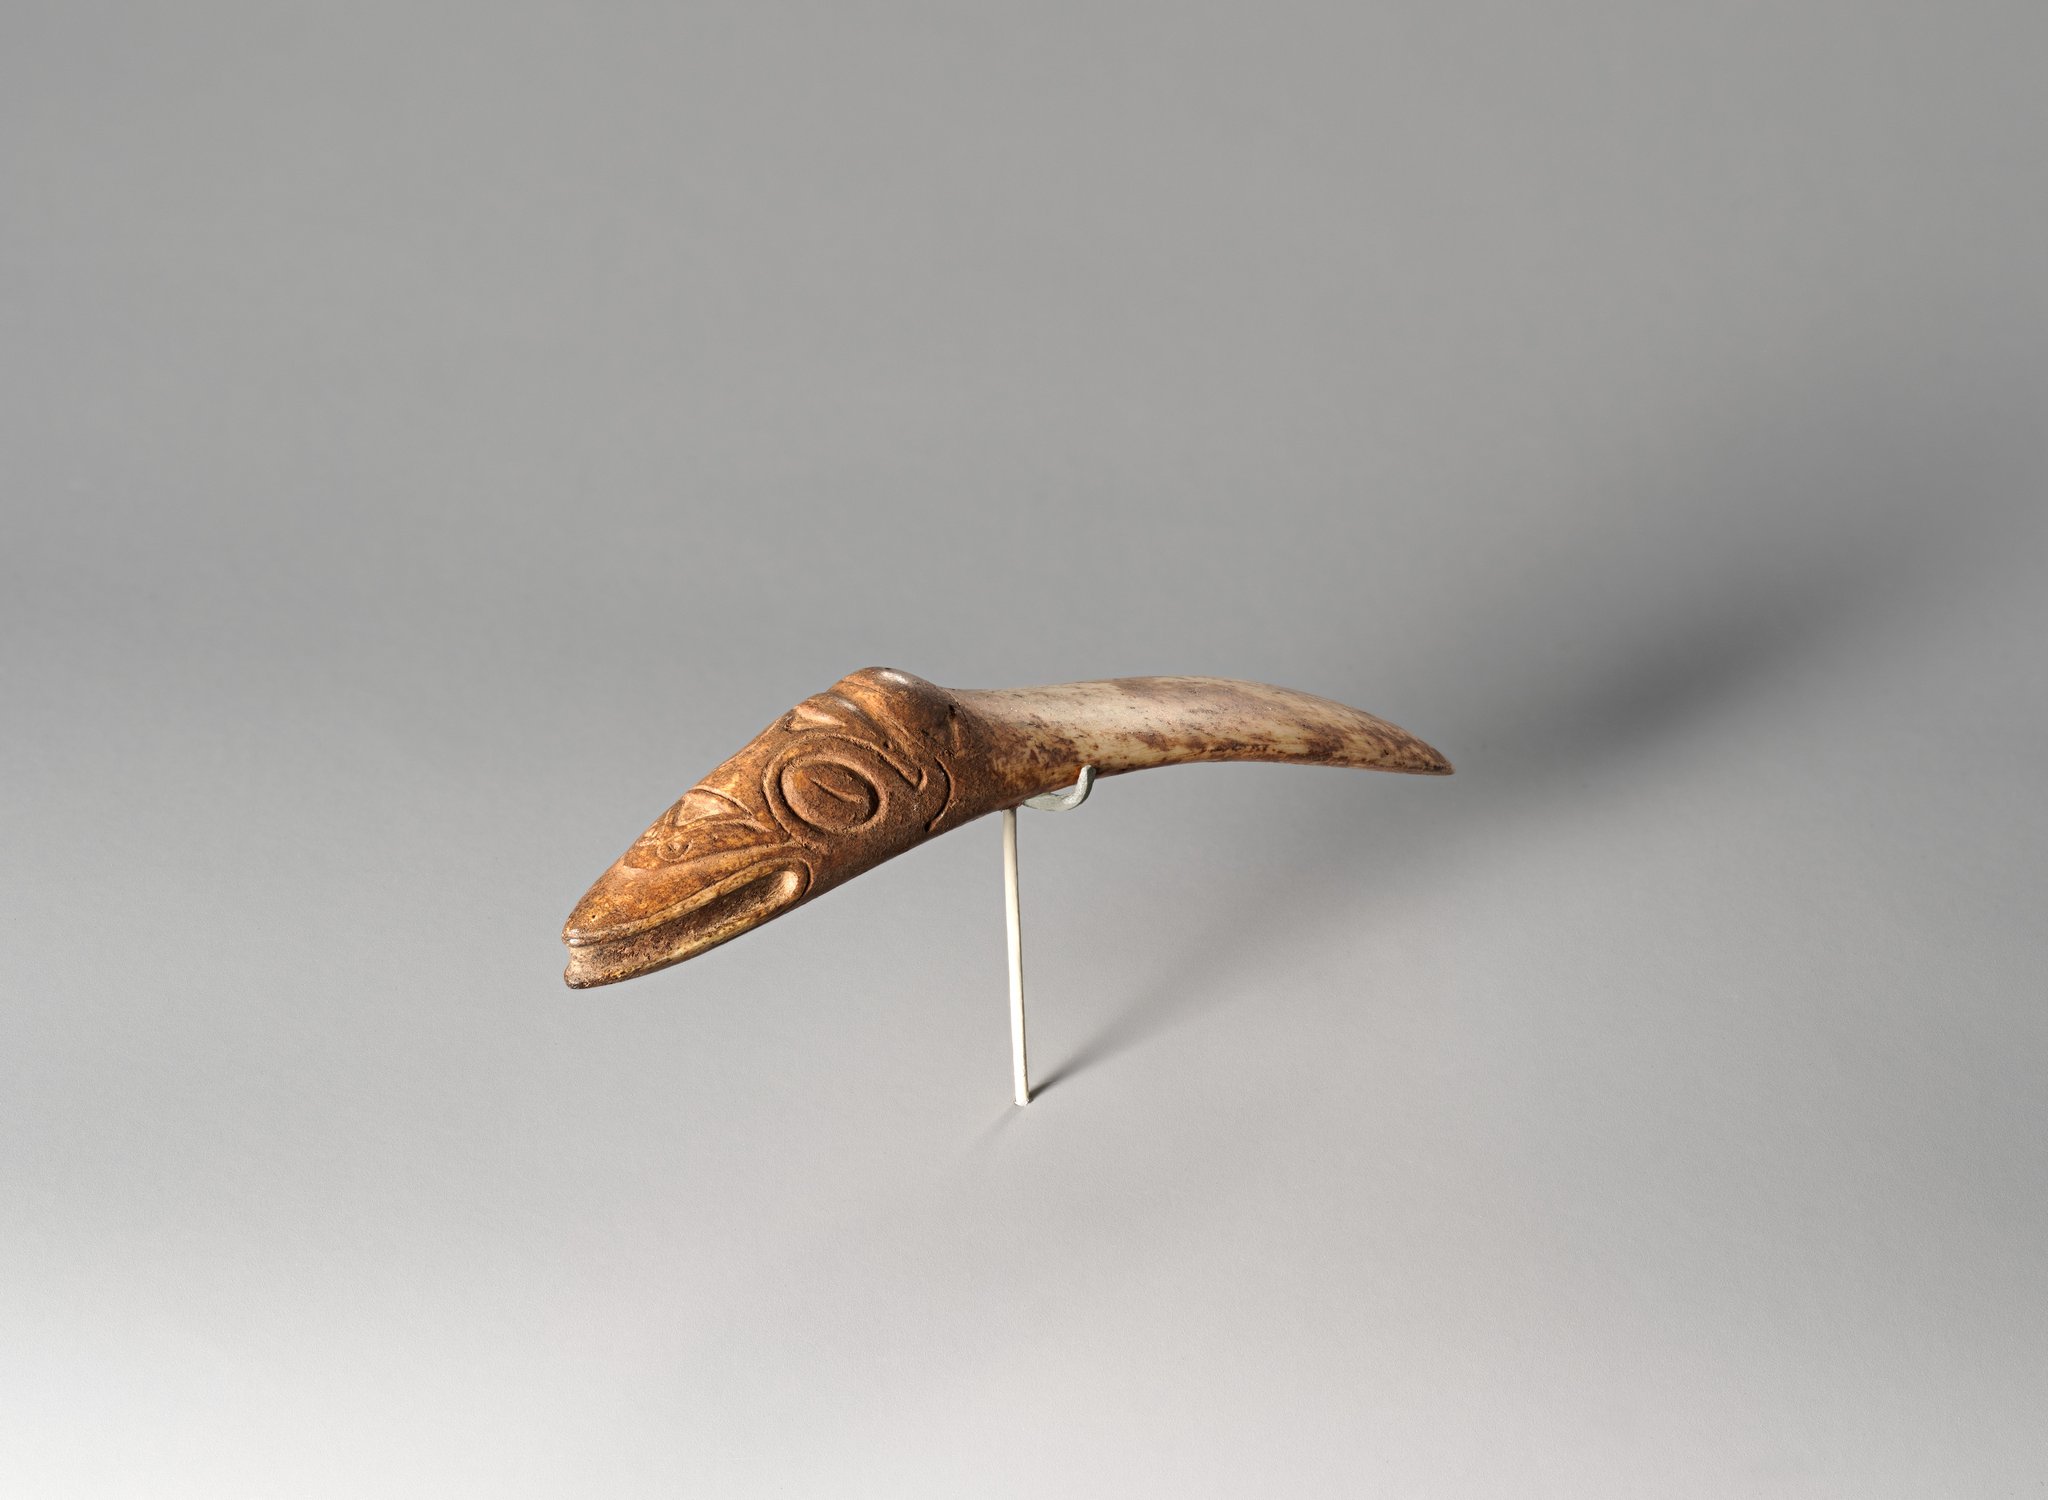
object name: spatula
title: Spatula (Vomitivo), Lizard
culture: taíno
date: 1201-1500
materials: bone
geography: dominican republic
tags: lizards